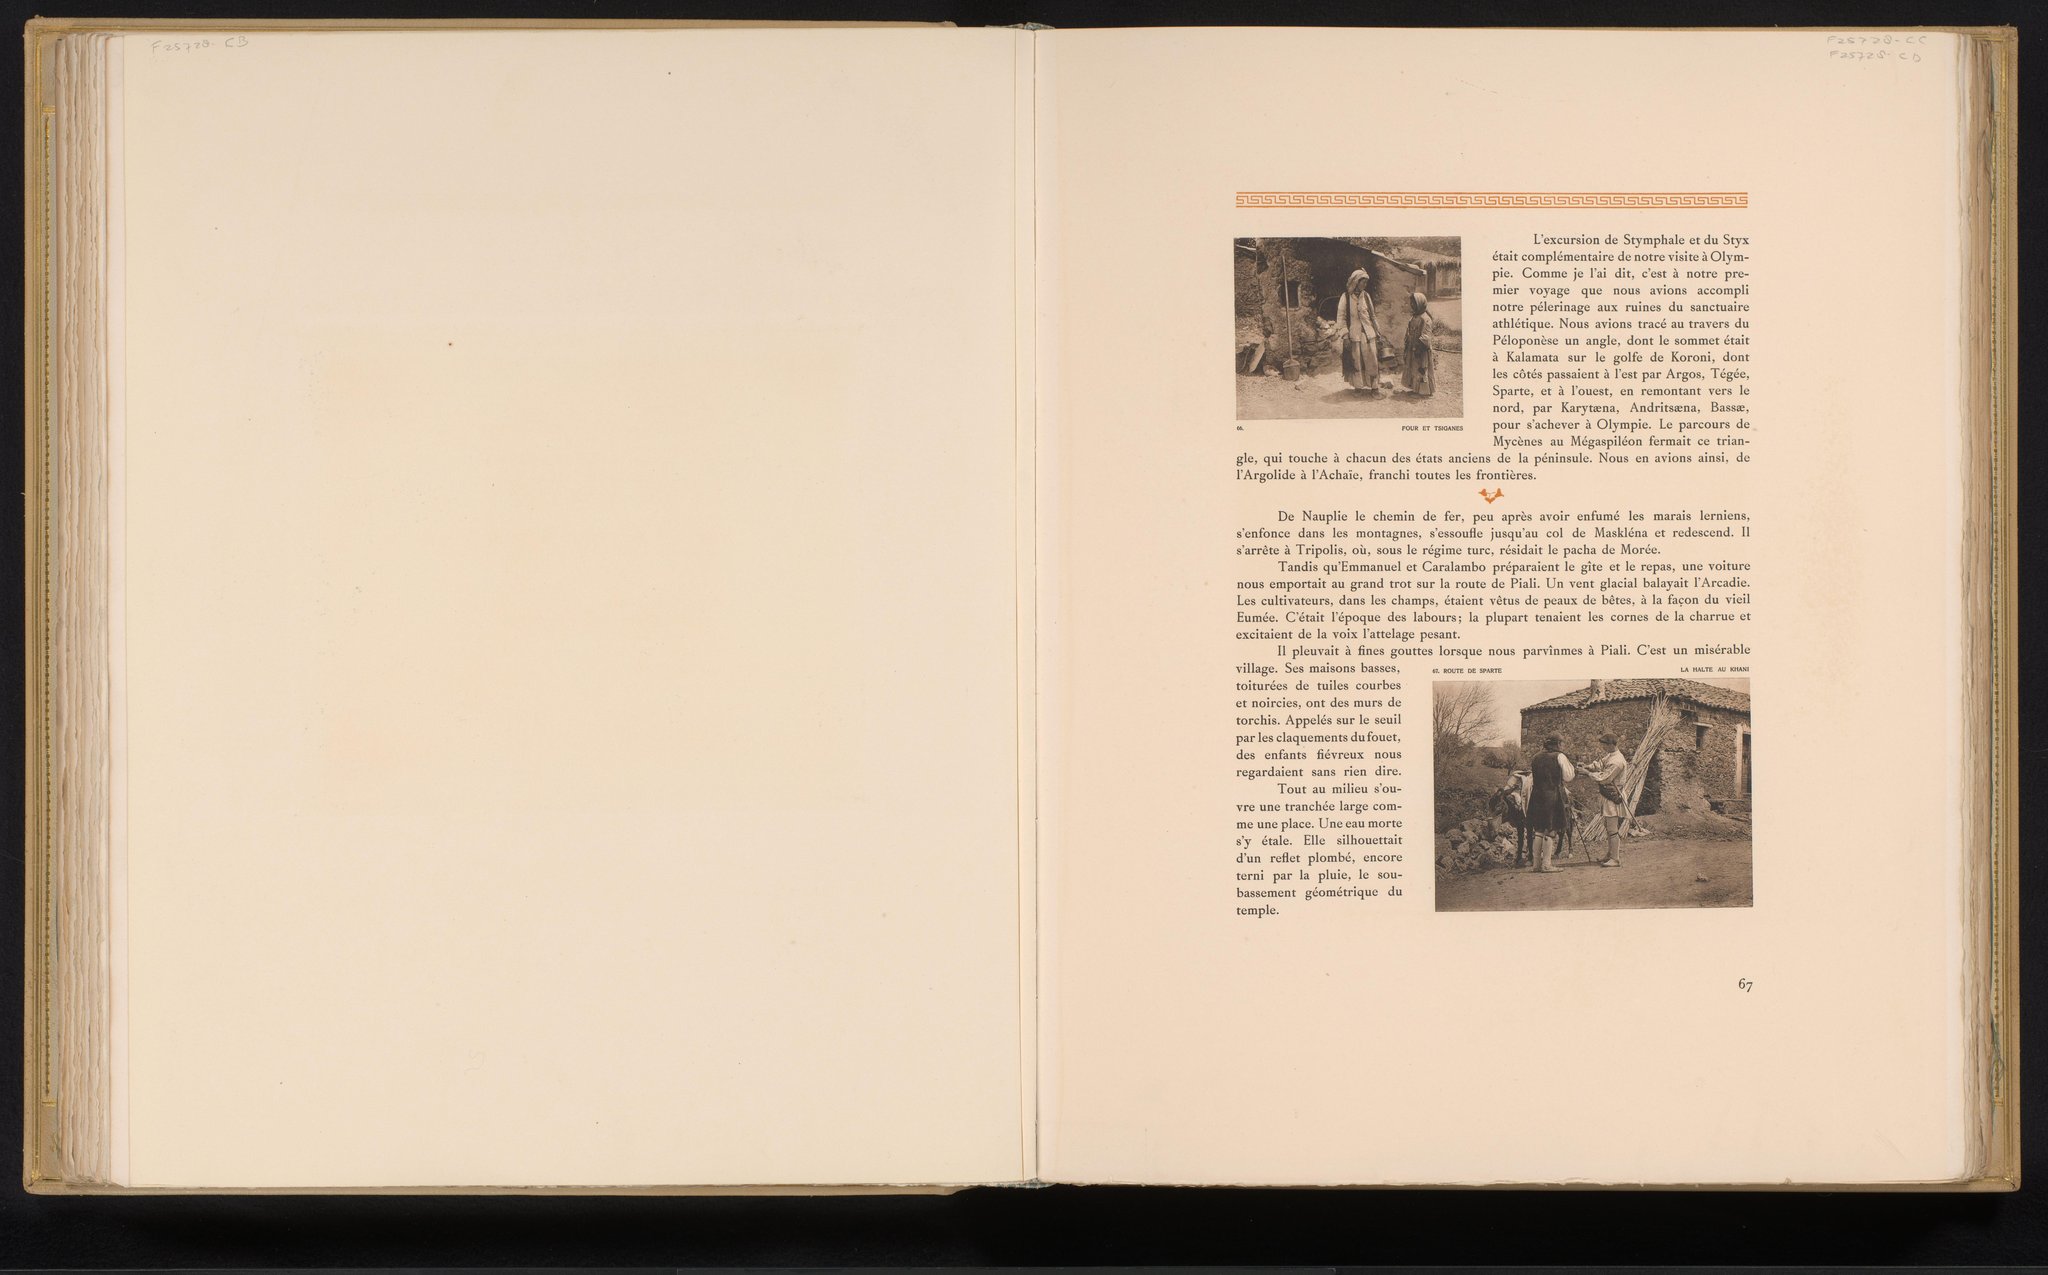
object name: photomechanical print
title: Twee reizigers op de weg naar Sparta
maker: frédéric boissonnas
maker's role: fotograaf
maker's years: 1858-1946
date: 1905-1910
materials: paper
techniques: photograph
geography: berlin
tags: (traveller) resting in the open air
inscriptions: number: ‘67.’